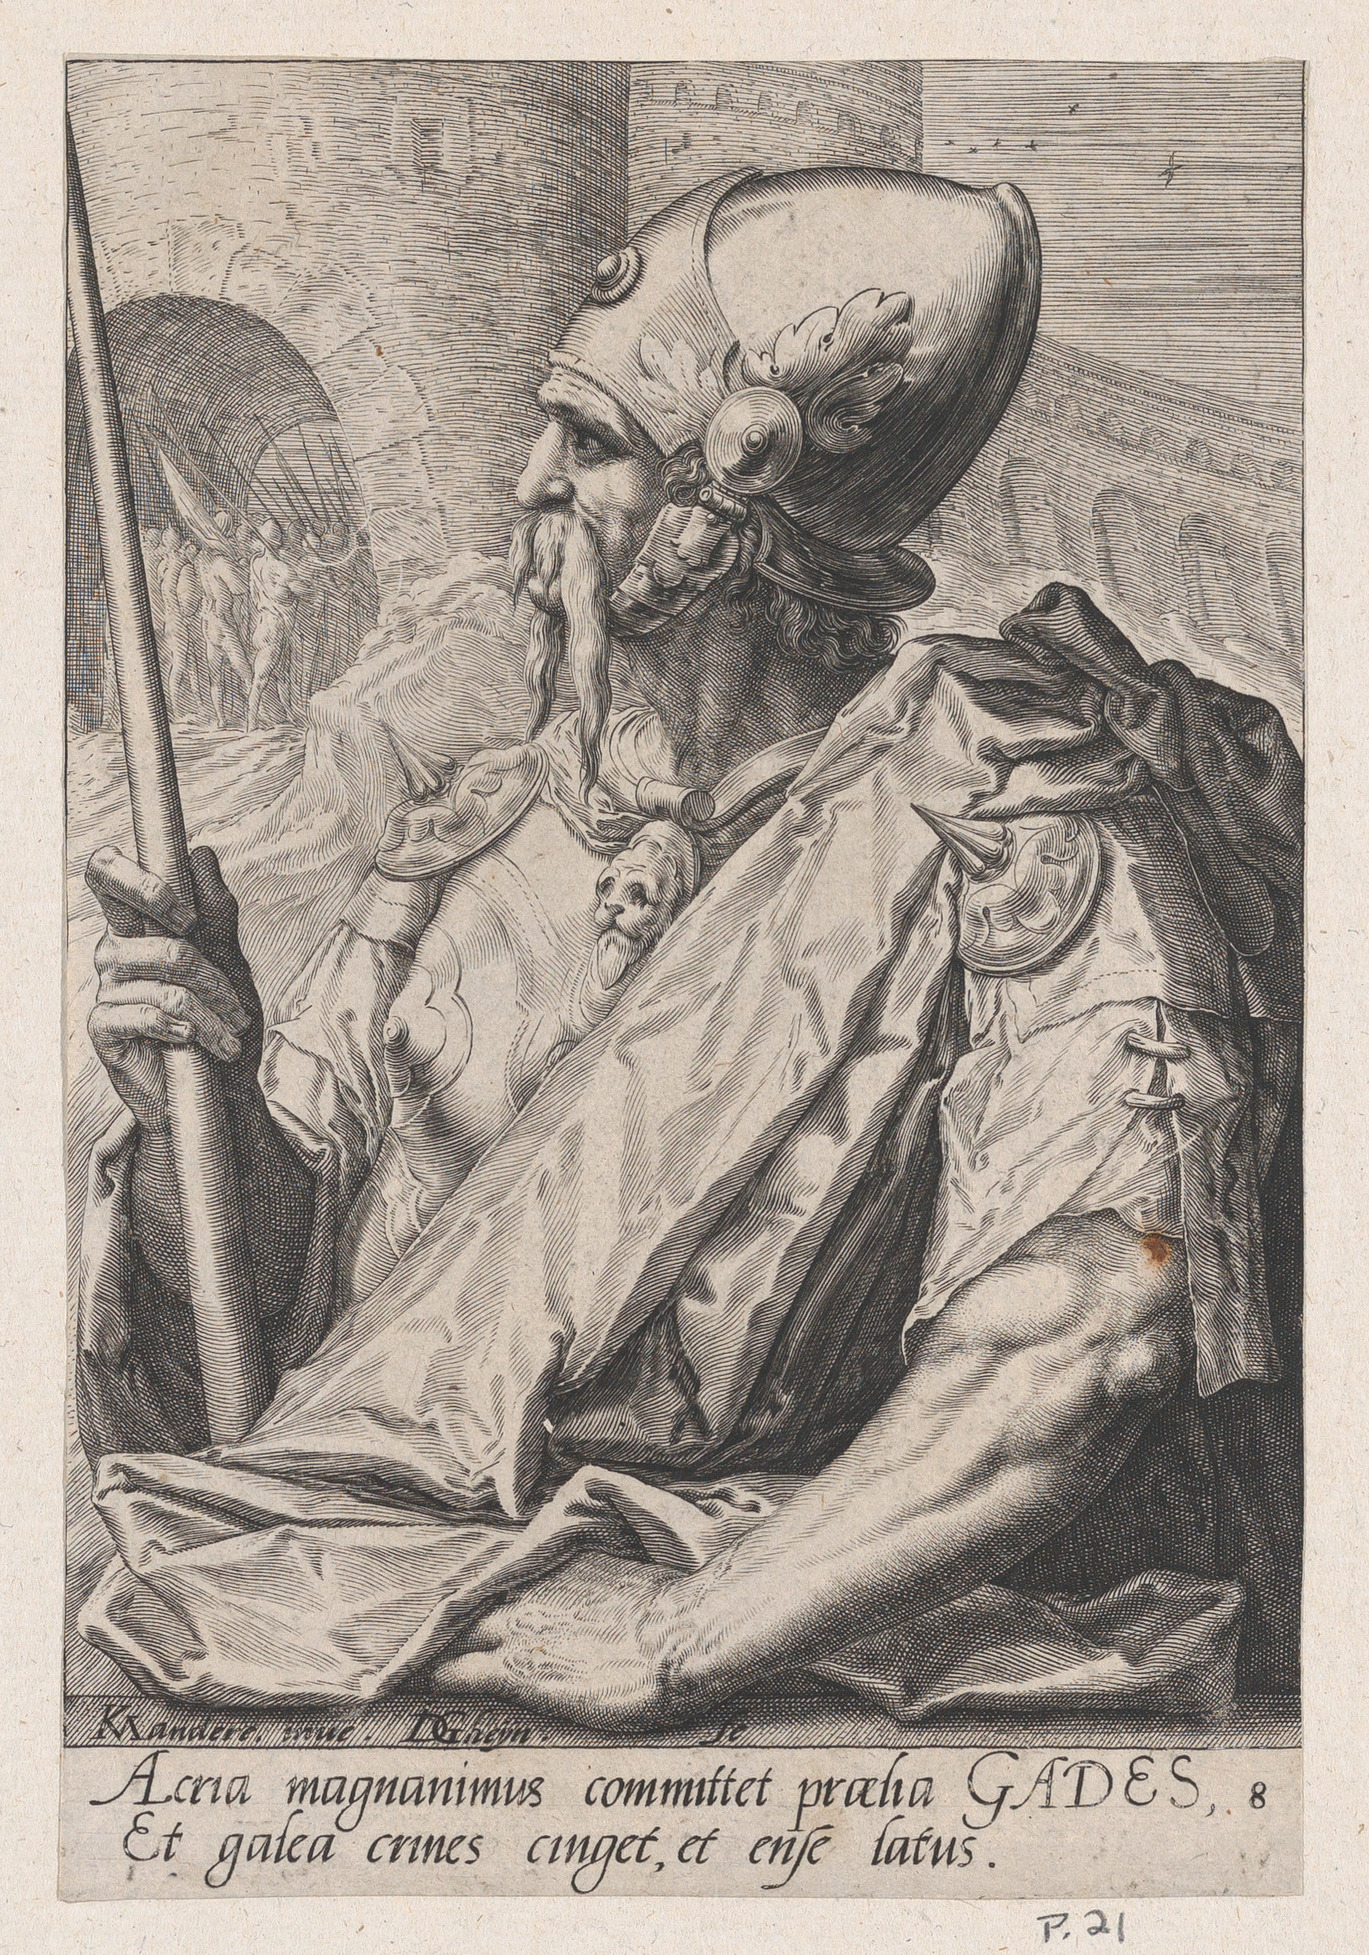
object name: print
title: Gad, from "The Twelve Sons of Jacob"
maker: jacques de gheyn (ii)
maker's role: artist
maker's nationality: netherlandish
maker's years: 1565-1629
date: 1584-1594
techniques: engraving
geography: amsterdam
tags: men,profiles